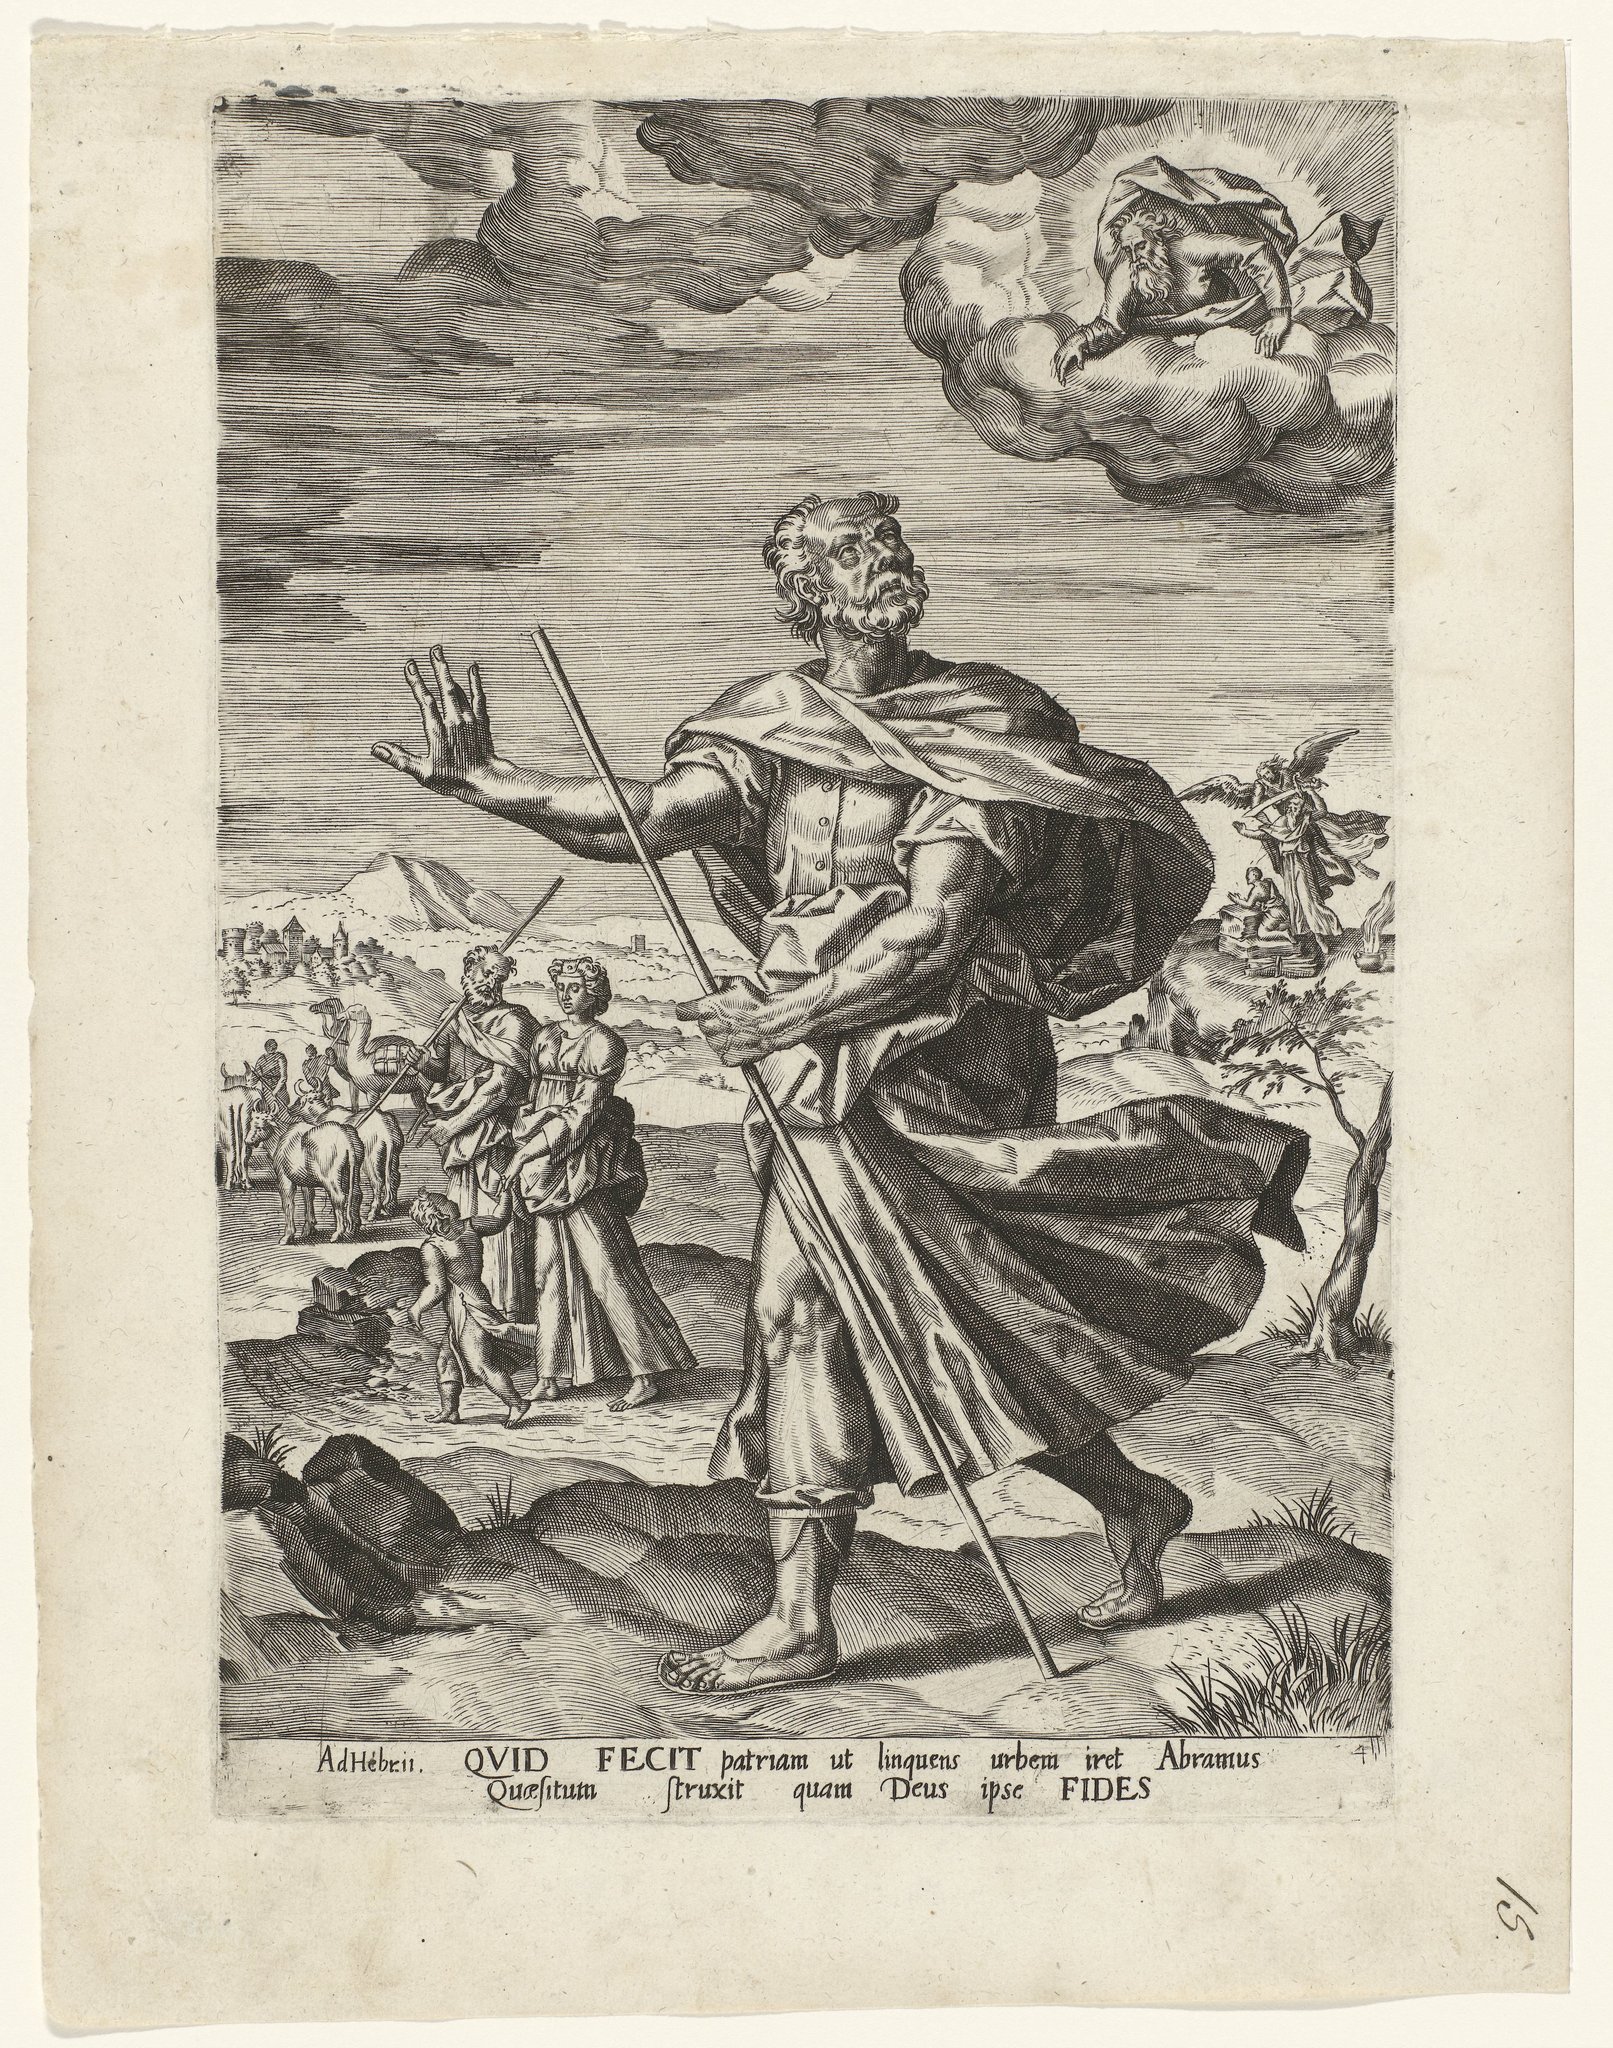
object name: print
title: De brief aan de Hebreeën hoofdstuk 11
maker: pieter jalhea furnius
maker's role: print maker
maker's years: 1540-1626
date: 1550-1625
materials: paper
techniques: engraving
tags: the calling of abraham, the sacrifice of isaac (genesis 22)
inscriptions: number: ‘15’, collector's mark: Lugt 2760, collector's mark: Lugt 2228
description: Abraham luistert naar God die vanuit een wolk tot hem spreekt. Links op de achtergrond staat Abraham met vrouw en kind bij zijn kudde. Rechts offert Abraham zijn zoon Isaak. Onder de afbeelding staat een tweeregelige tekst in het Latijn, rechts in de marge genummerd: 4. De prent maakt deel uit van een serie prenten over de Brief aan de Hebreeën hoofdstuk 11.